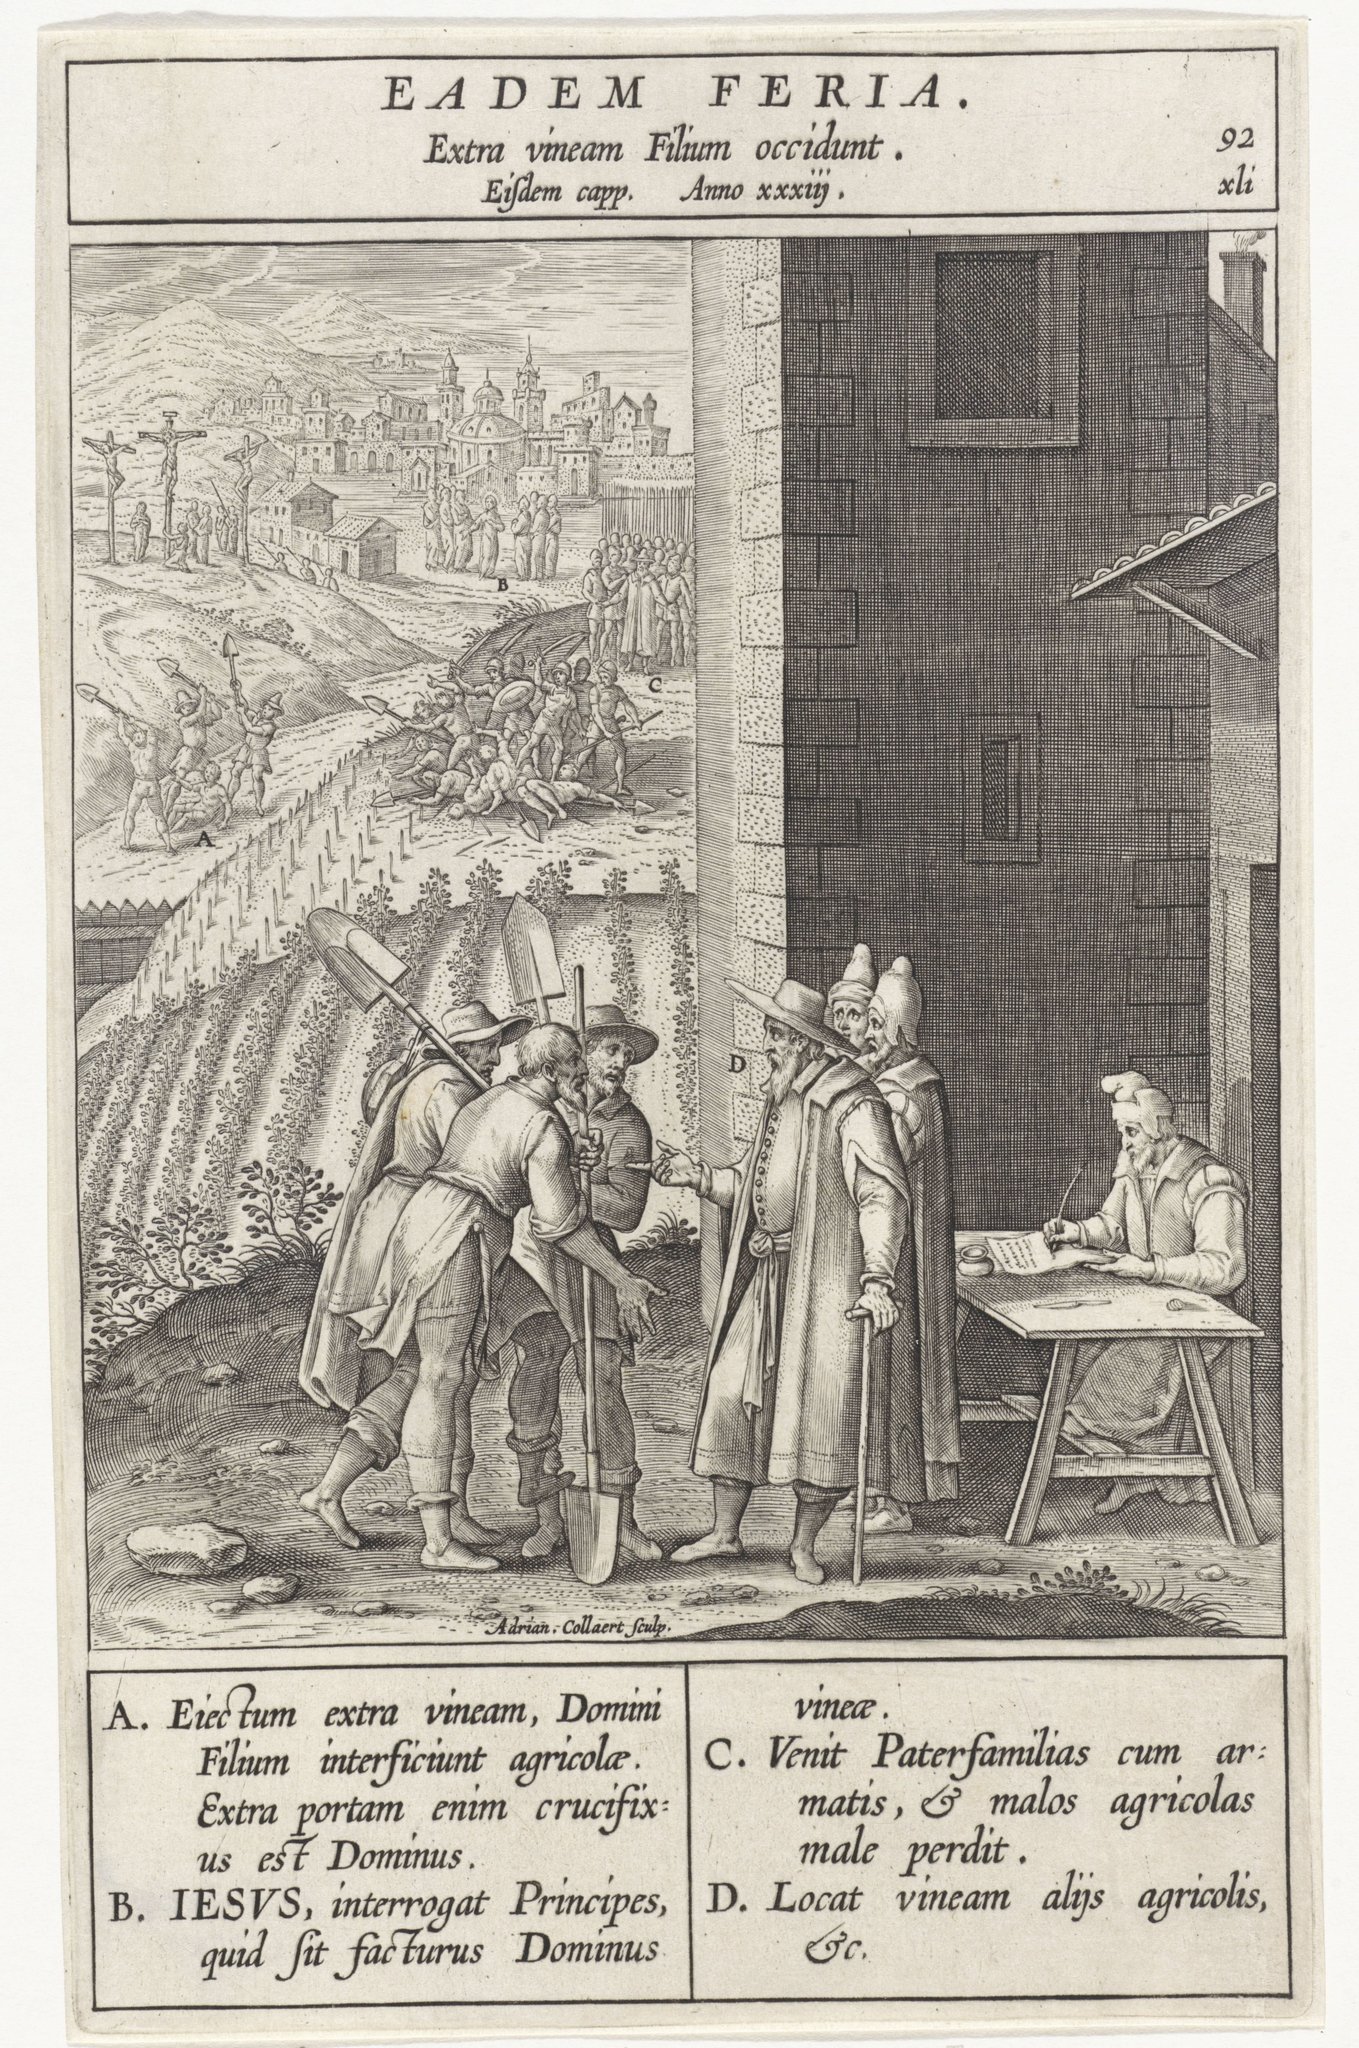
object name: print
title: Eadem Feria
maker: adriaen collaert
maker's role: draughtsman, print maker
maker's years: 1560-1618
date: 1593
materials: paper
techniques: engraving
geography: antwerp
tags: at last the lord sends his son, '... they cast him out of the vineyard, and killed him', the wicked husbandmen kill the servants of the lord, who are sent to gather the fruits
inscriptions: collector's mark: Lugt 2228, collector's mark: Lugt 2165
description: De landheer stuurt knechten naar de pachters om zijn fruit in ontvangst te nemen. Op de achtergrond is te zien hoe de pachters de knechten mishandelen en de zoon van de landheer doden om zo zijn erfenis op te strijken. Bij verschillende elementen uit de voorstelling staan letters die corresponderen met de legenda in de marge.